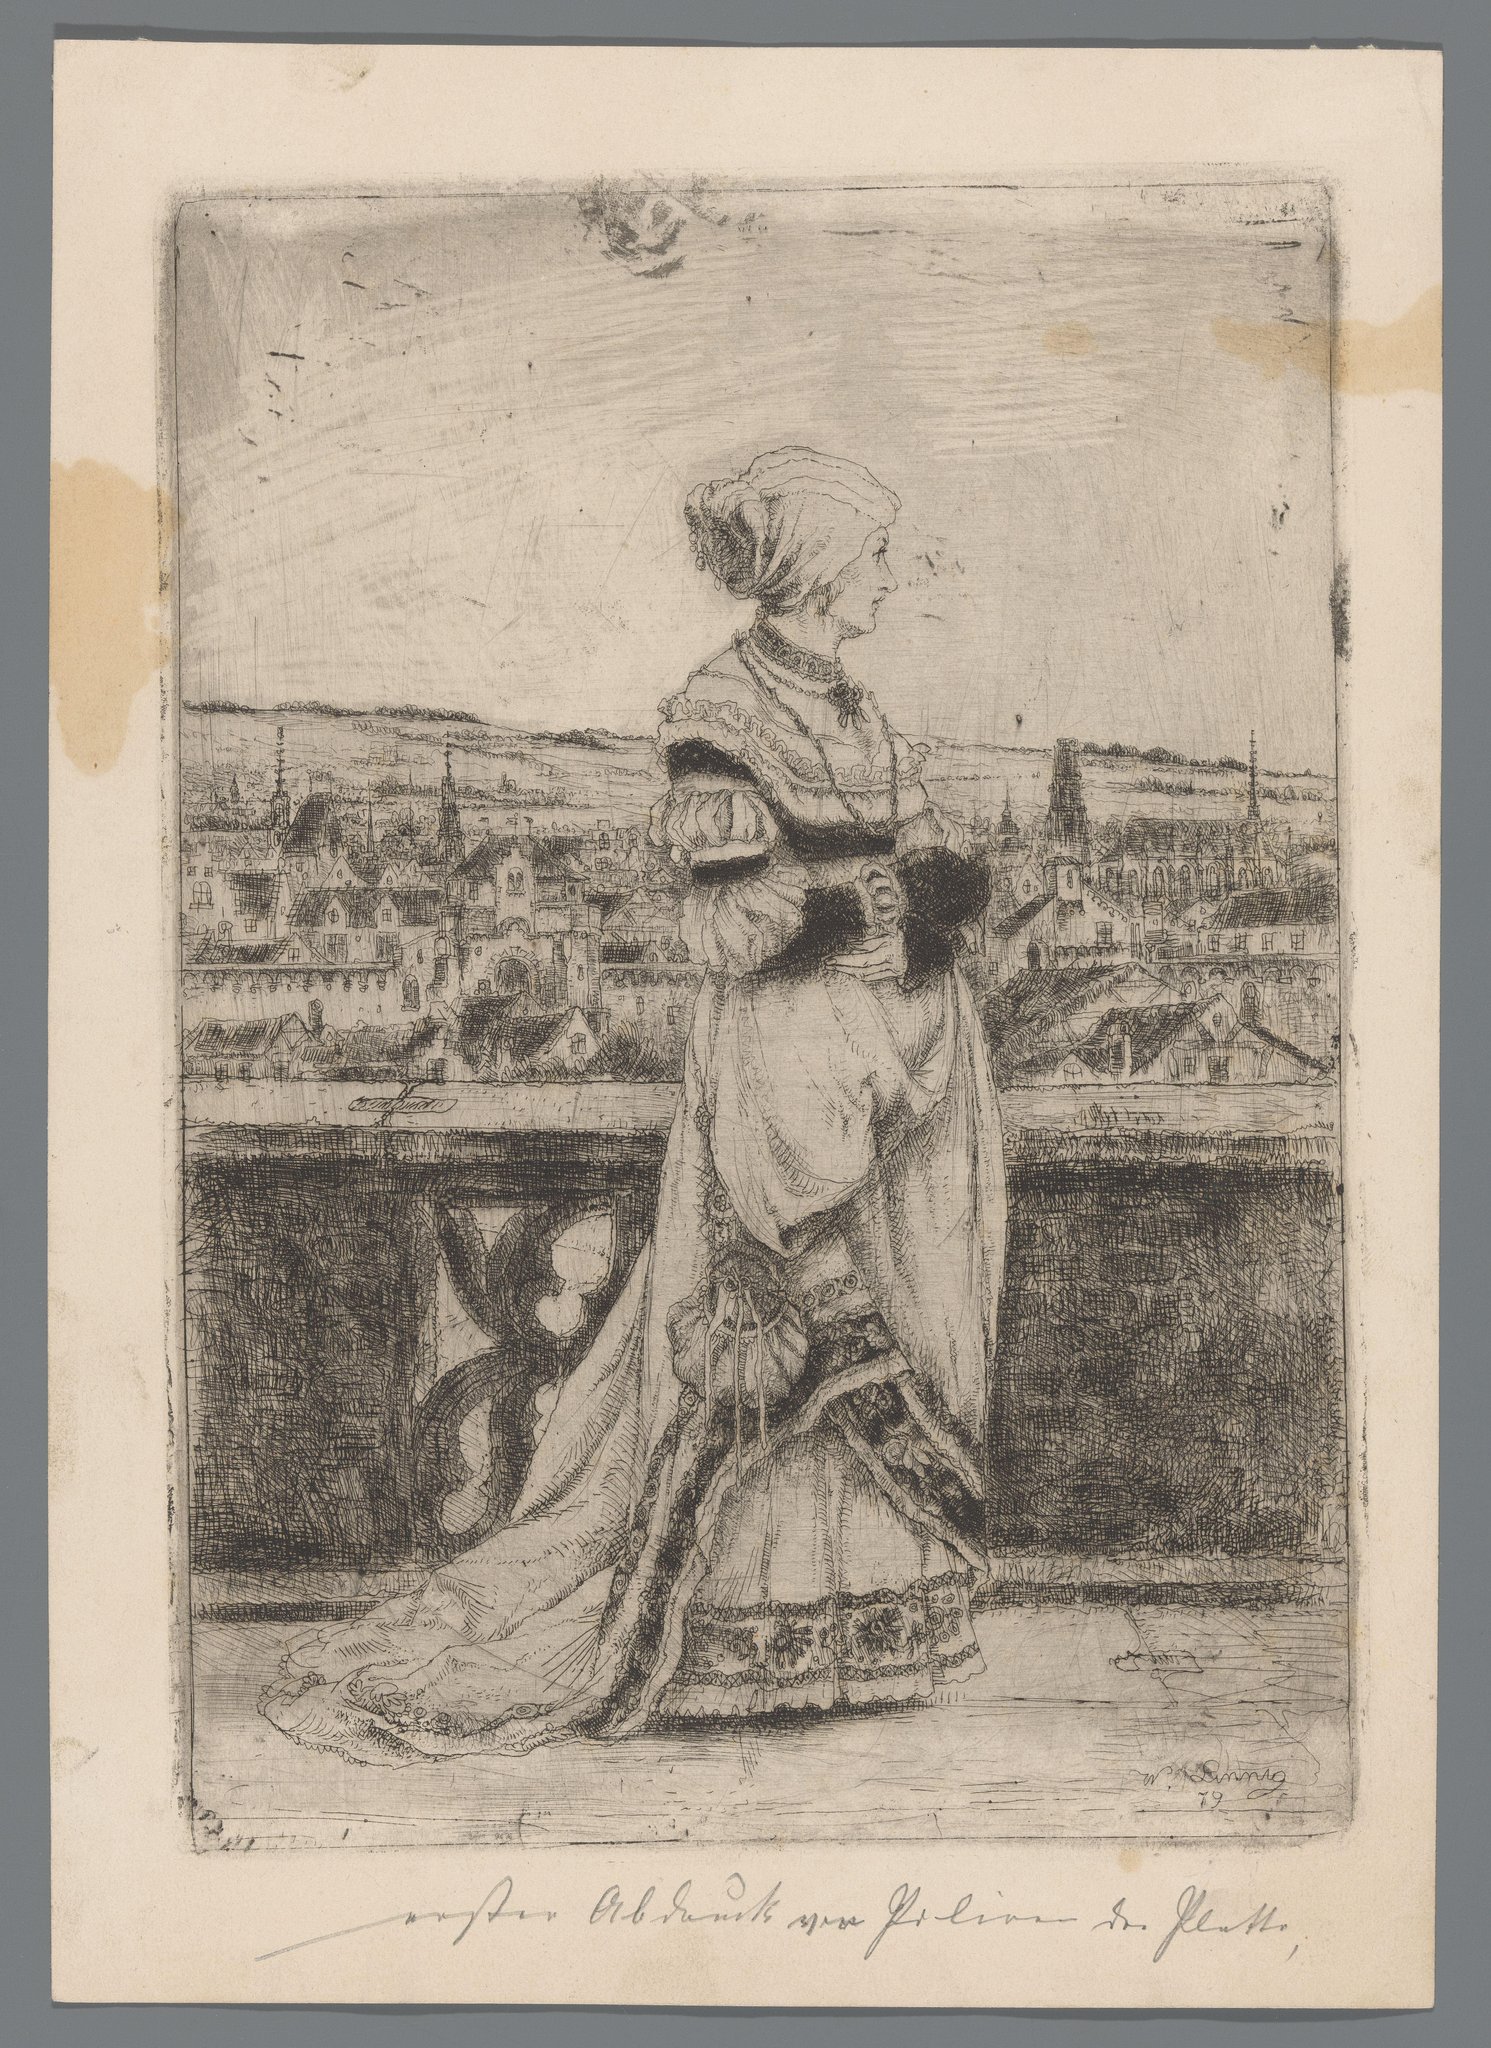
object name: print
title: Dame wandelend op een terras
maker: willem linnig (ii)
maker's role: print maker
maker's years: 1842-1890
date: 1879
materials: paper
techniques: etching, intaglio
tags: adult woman, walking, hiking (recreation)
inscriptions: annotation: ‘[...] Abdrück [...]’